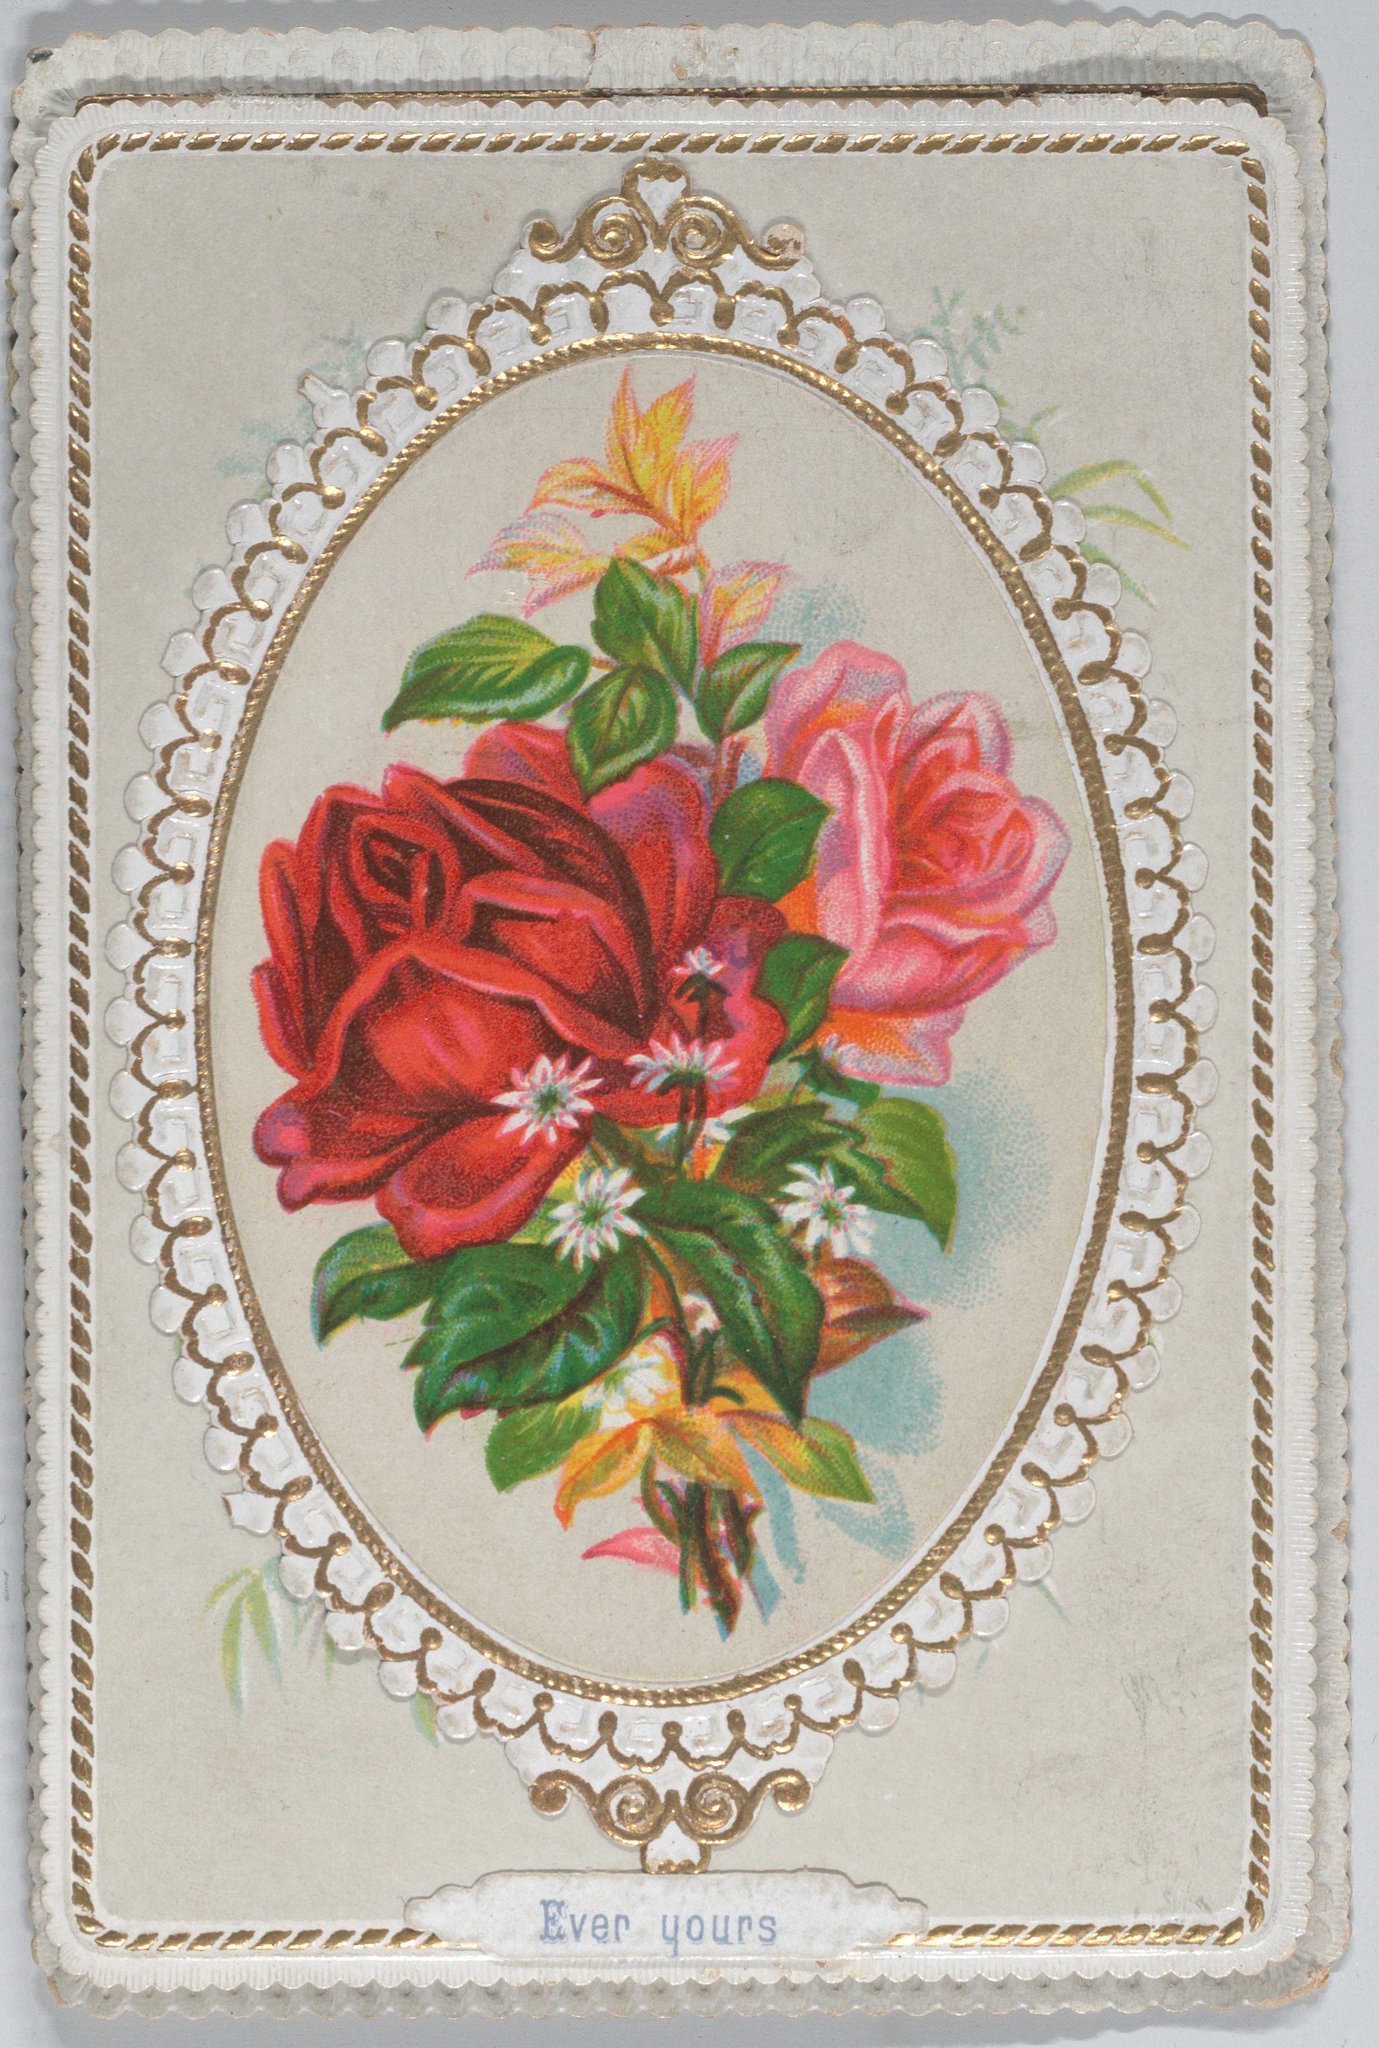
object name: valentine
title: Valentine - Mechanical organ grinder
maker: anonymous, british, 19th century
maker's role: artist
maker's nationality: british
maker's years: 1800-1900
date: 1875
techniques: chromolithography, cutting, gilding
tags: flowers